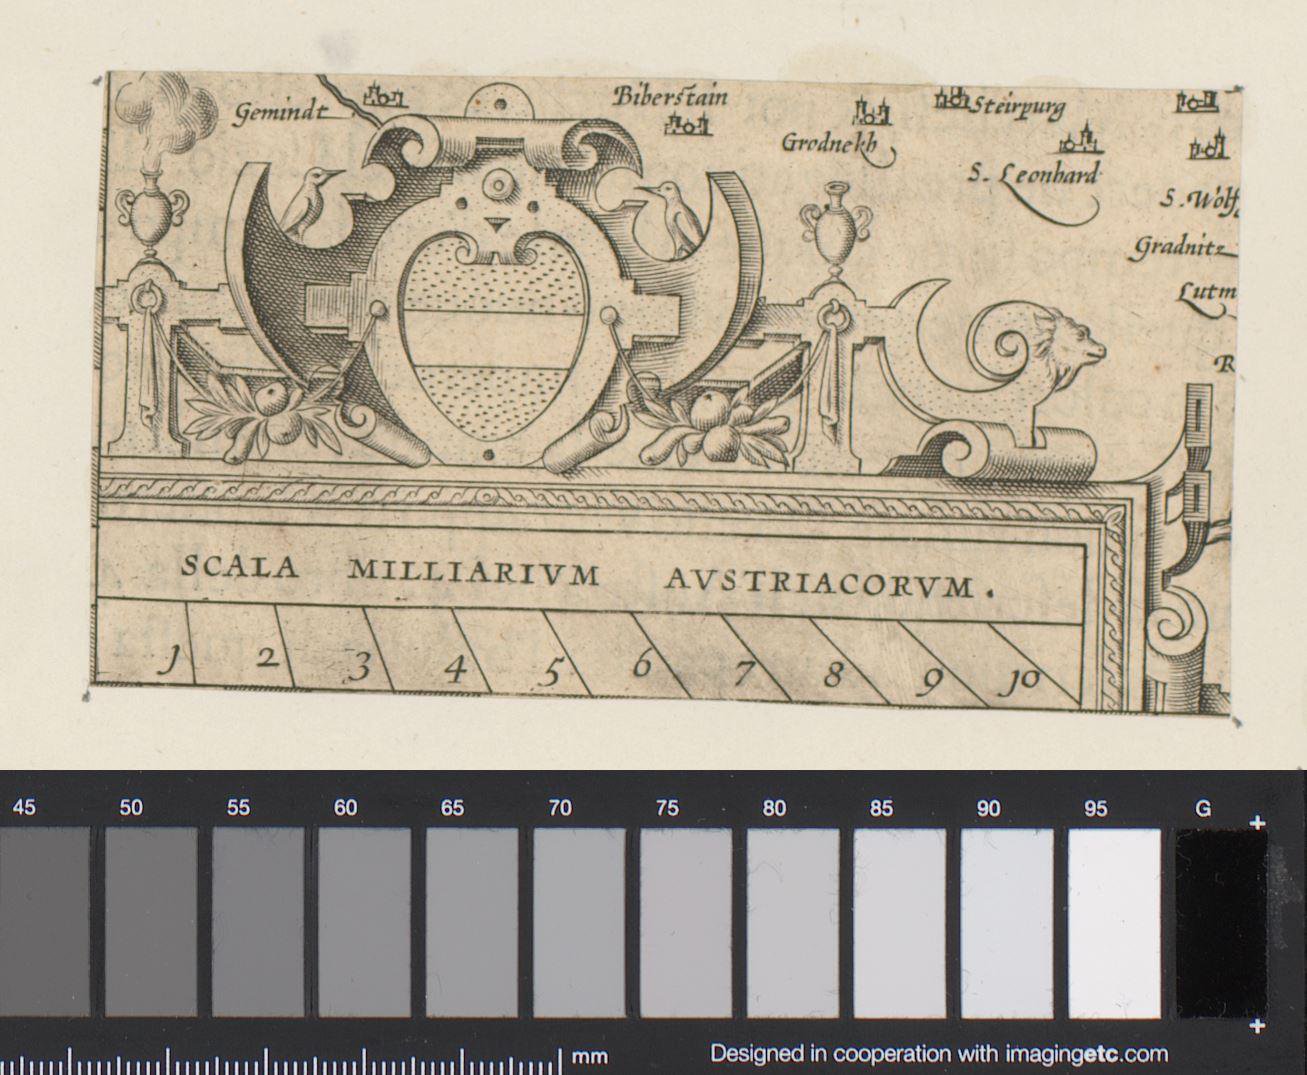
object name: print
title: Cartouche met het wapen van Oostenrijk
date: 1592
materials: paper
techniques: engraving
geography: antwerp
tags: coat of arms (as symbol of the state, etc.), scrollwork, strapwork ~ ornament, ornament ~ cartouche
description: Rechthoekige liggende hoekcartouche met schaalstok (Scala Milliarium Austriacorum). Midden boven een hartvormig schild met het wapen van Oostenrijk. De cartouche is een fragment van een kaart van Oostenrijk. De prent maakt deel uit van een album.